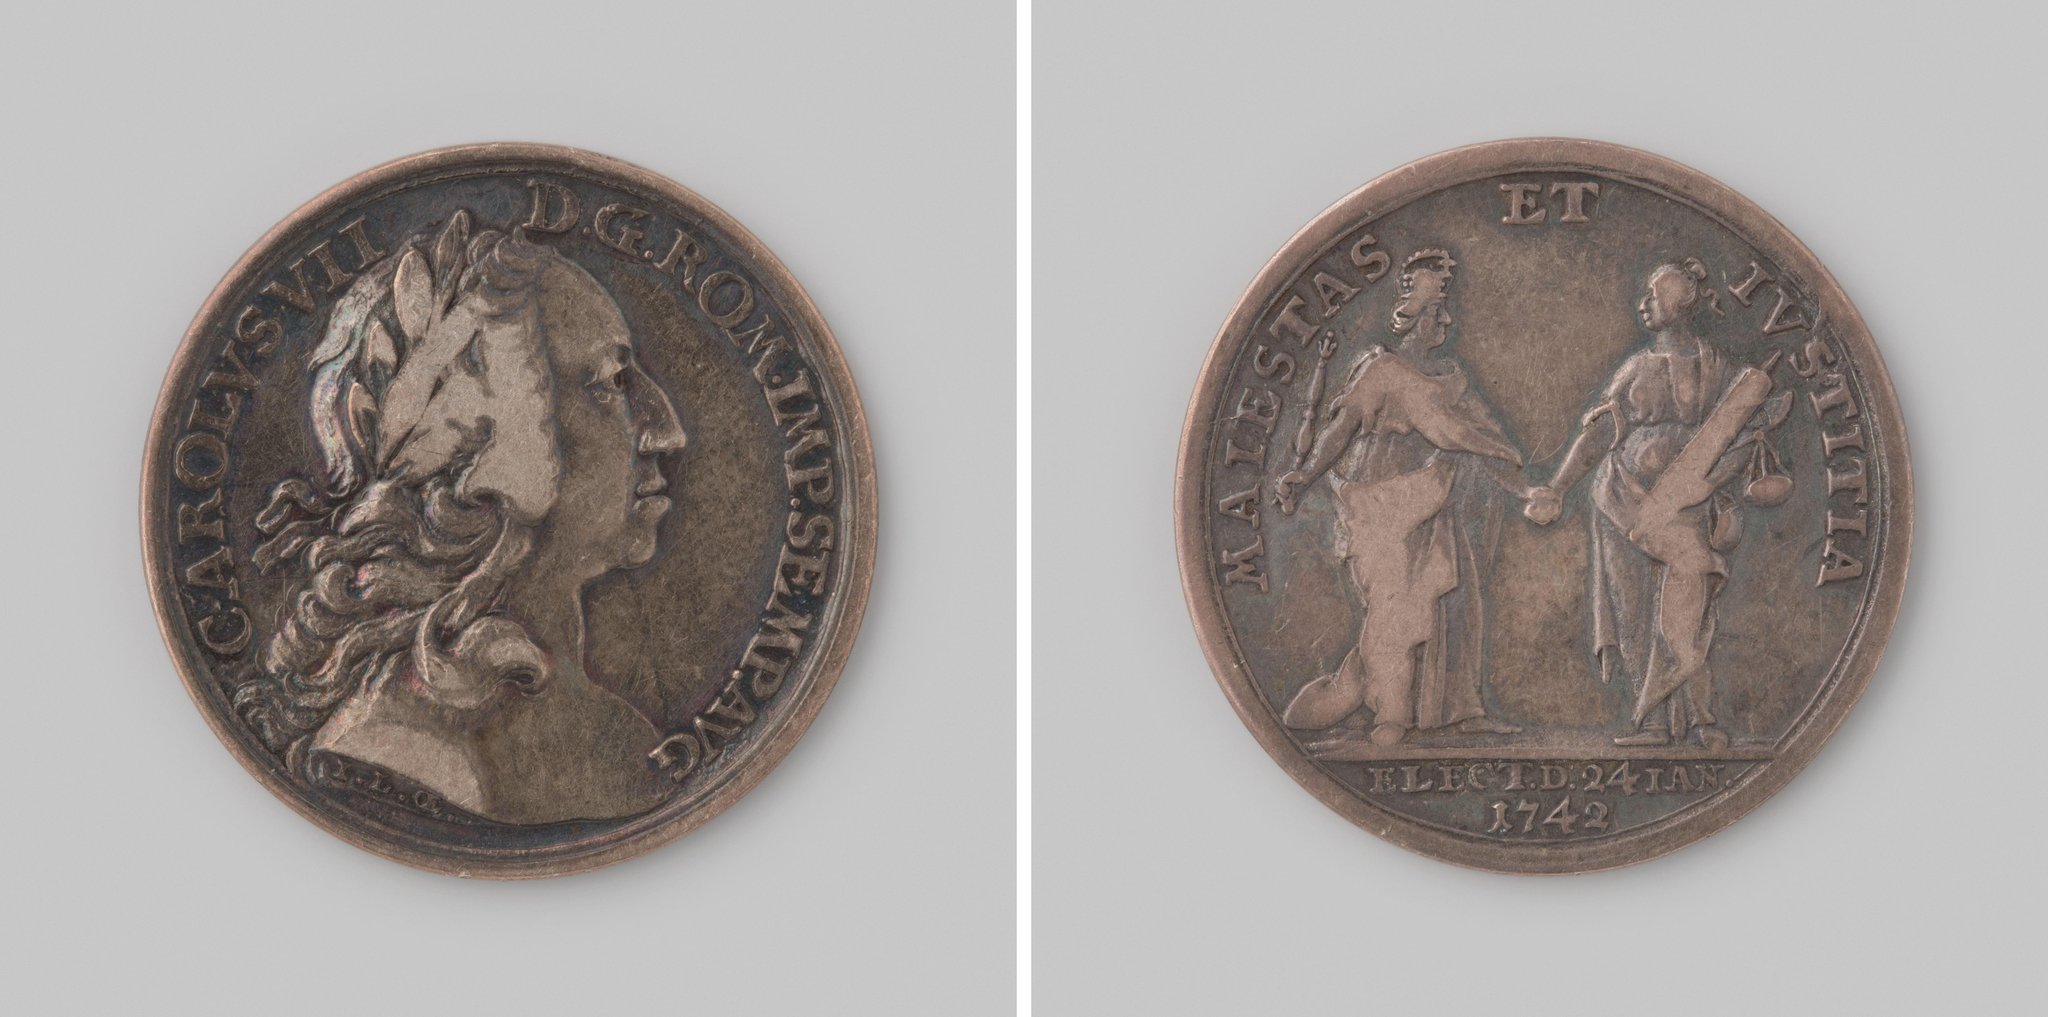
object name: history medal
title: Verkiezing van Karel VII tot Keizer van Duitsland 1742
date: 1742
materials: silver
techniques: striking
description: Zilveren penning, op de voorzijde het borstbeeld van Karel VII neer rechts met omschrift, op de keerzijde Majestas en Justitia elkaar de hand schuddend, met omschrift en afsnedetekst.